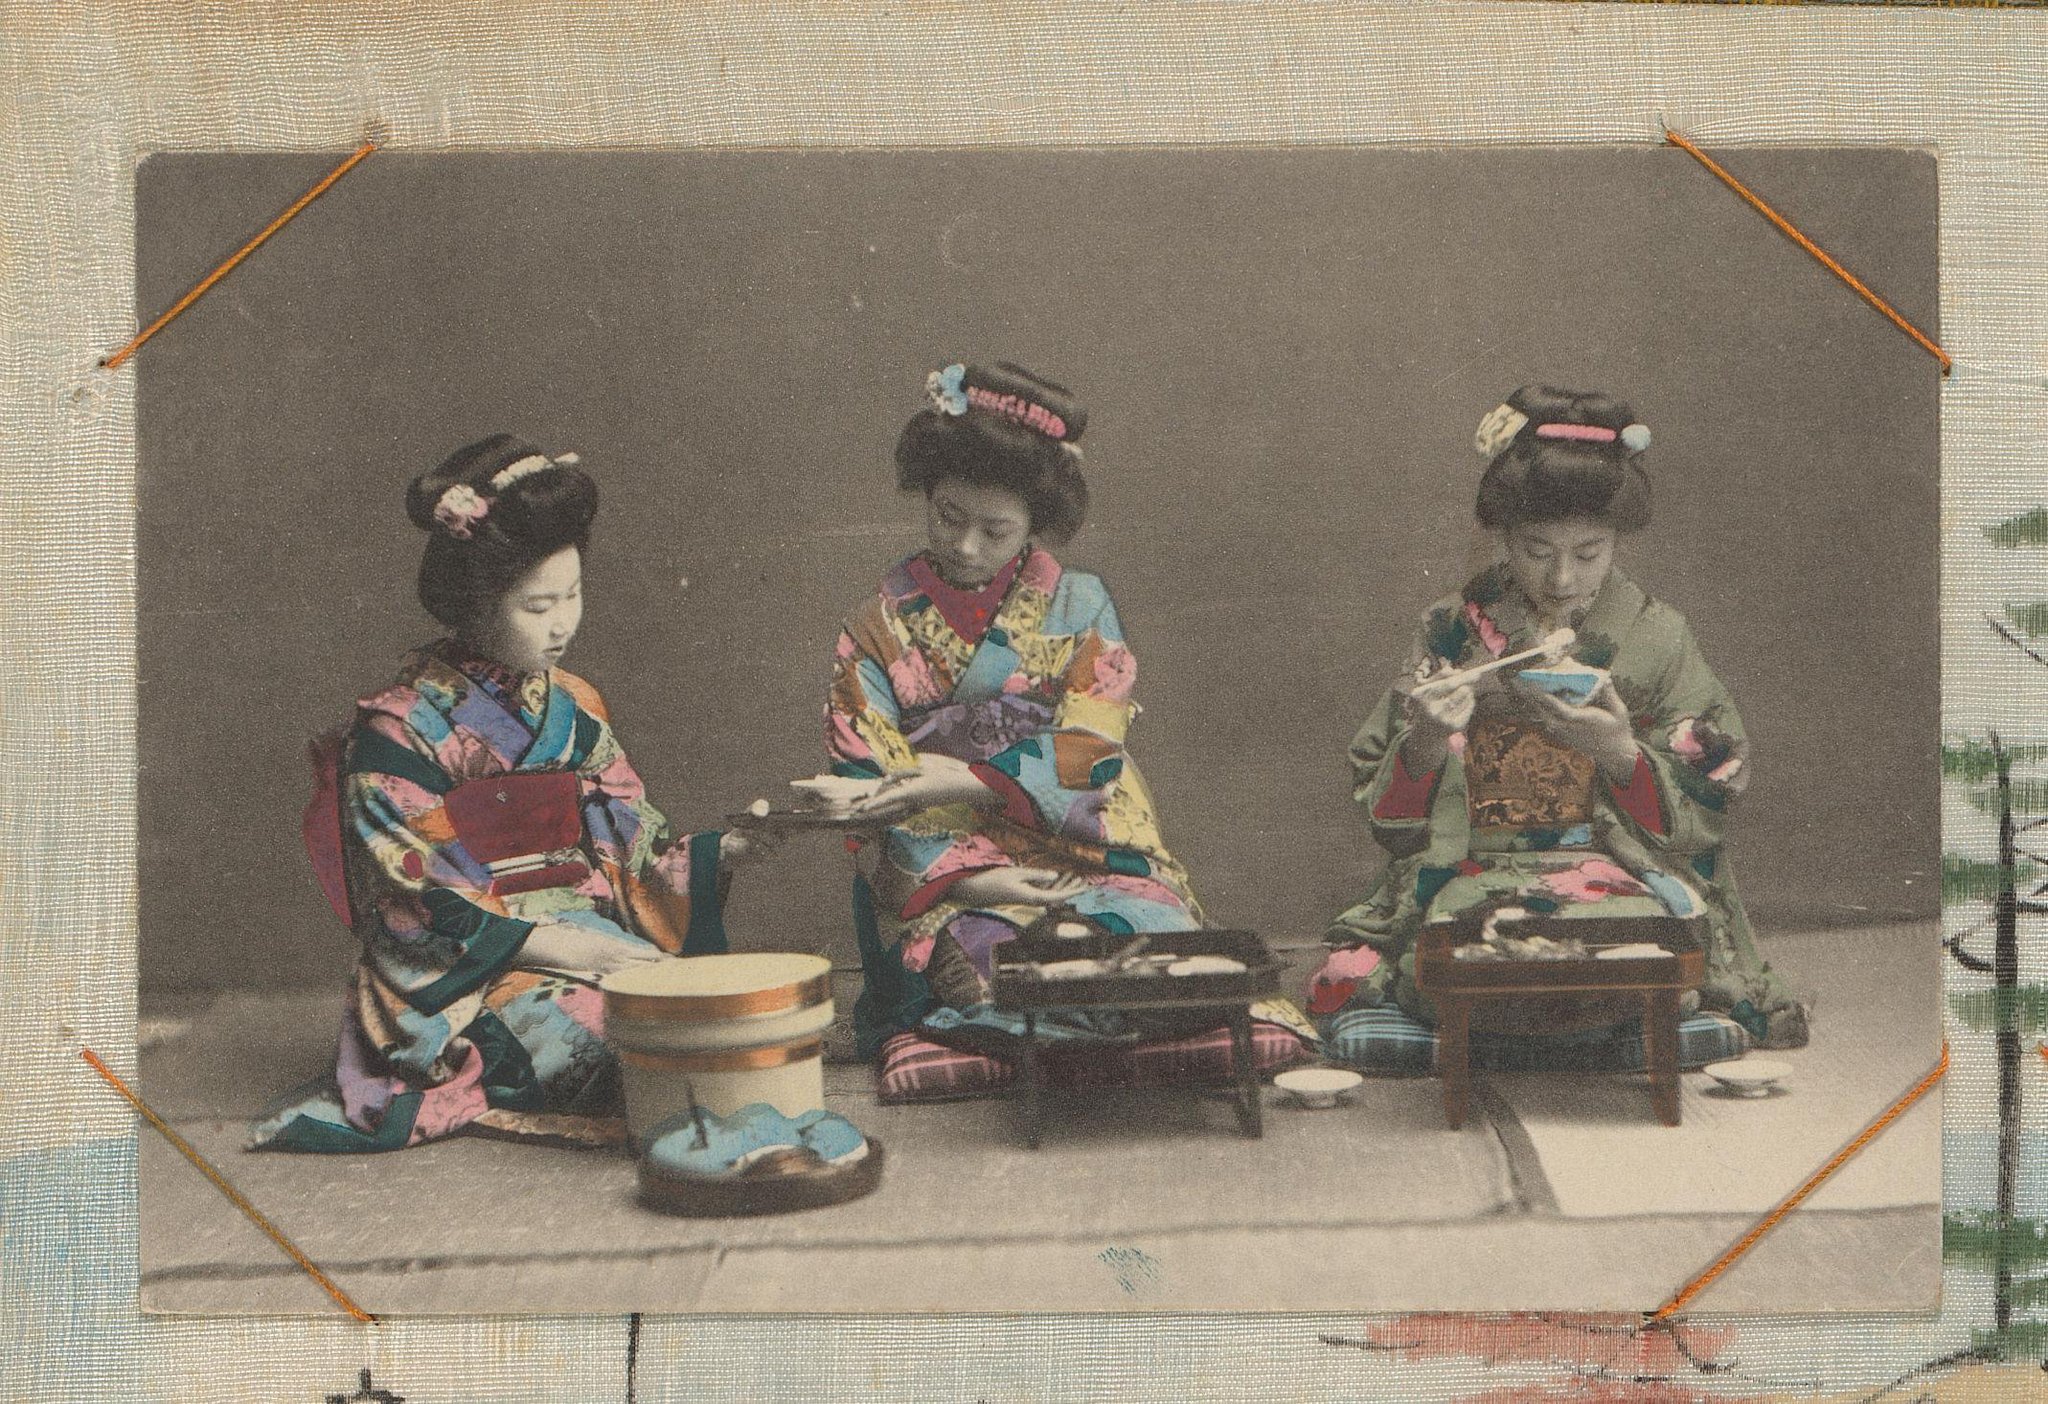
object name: photomechanical print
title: Drie Japanse vrouwen in gekleurde kimono's eten rijst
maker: Anonymous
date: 1900-1920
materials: paper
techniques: photograph, hand coloring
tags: historical persons, adult woman (+ three persons), cereal, grain, corn (grass with grains, grown for food, e.g.: wheat, rice, rye, oats, maize, buckwheat, millet), folk costume, regional costume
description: Deze prent maakt deel uit van een album.